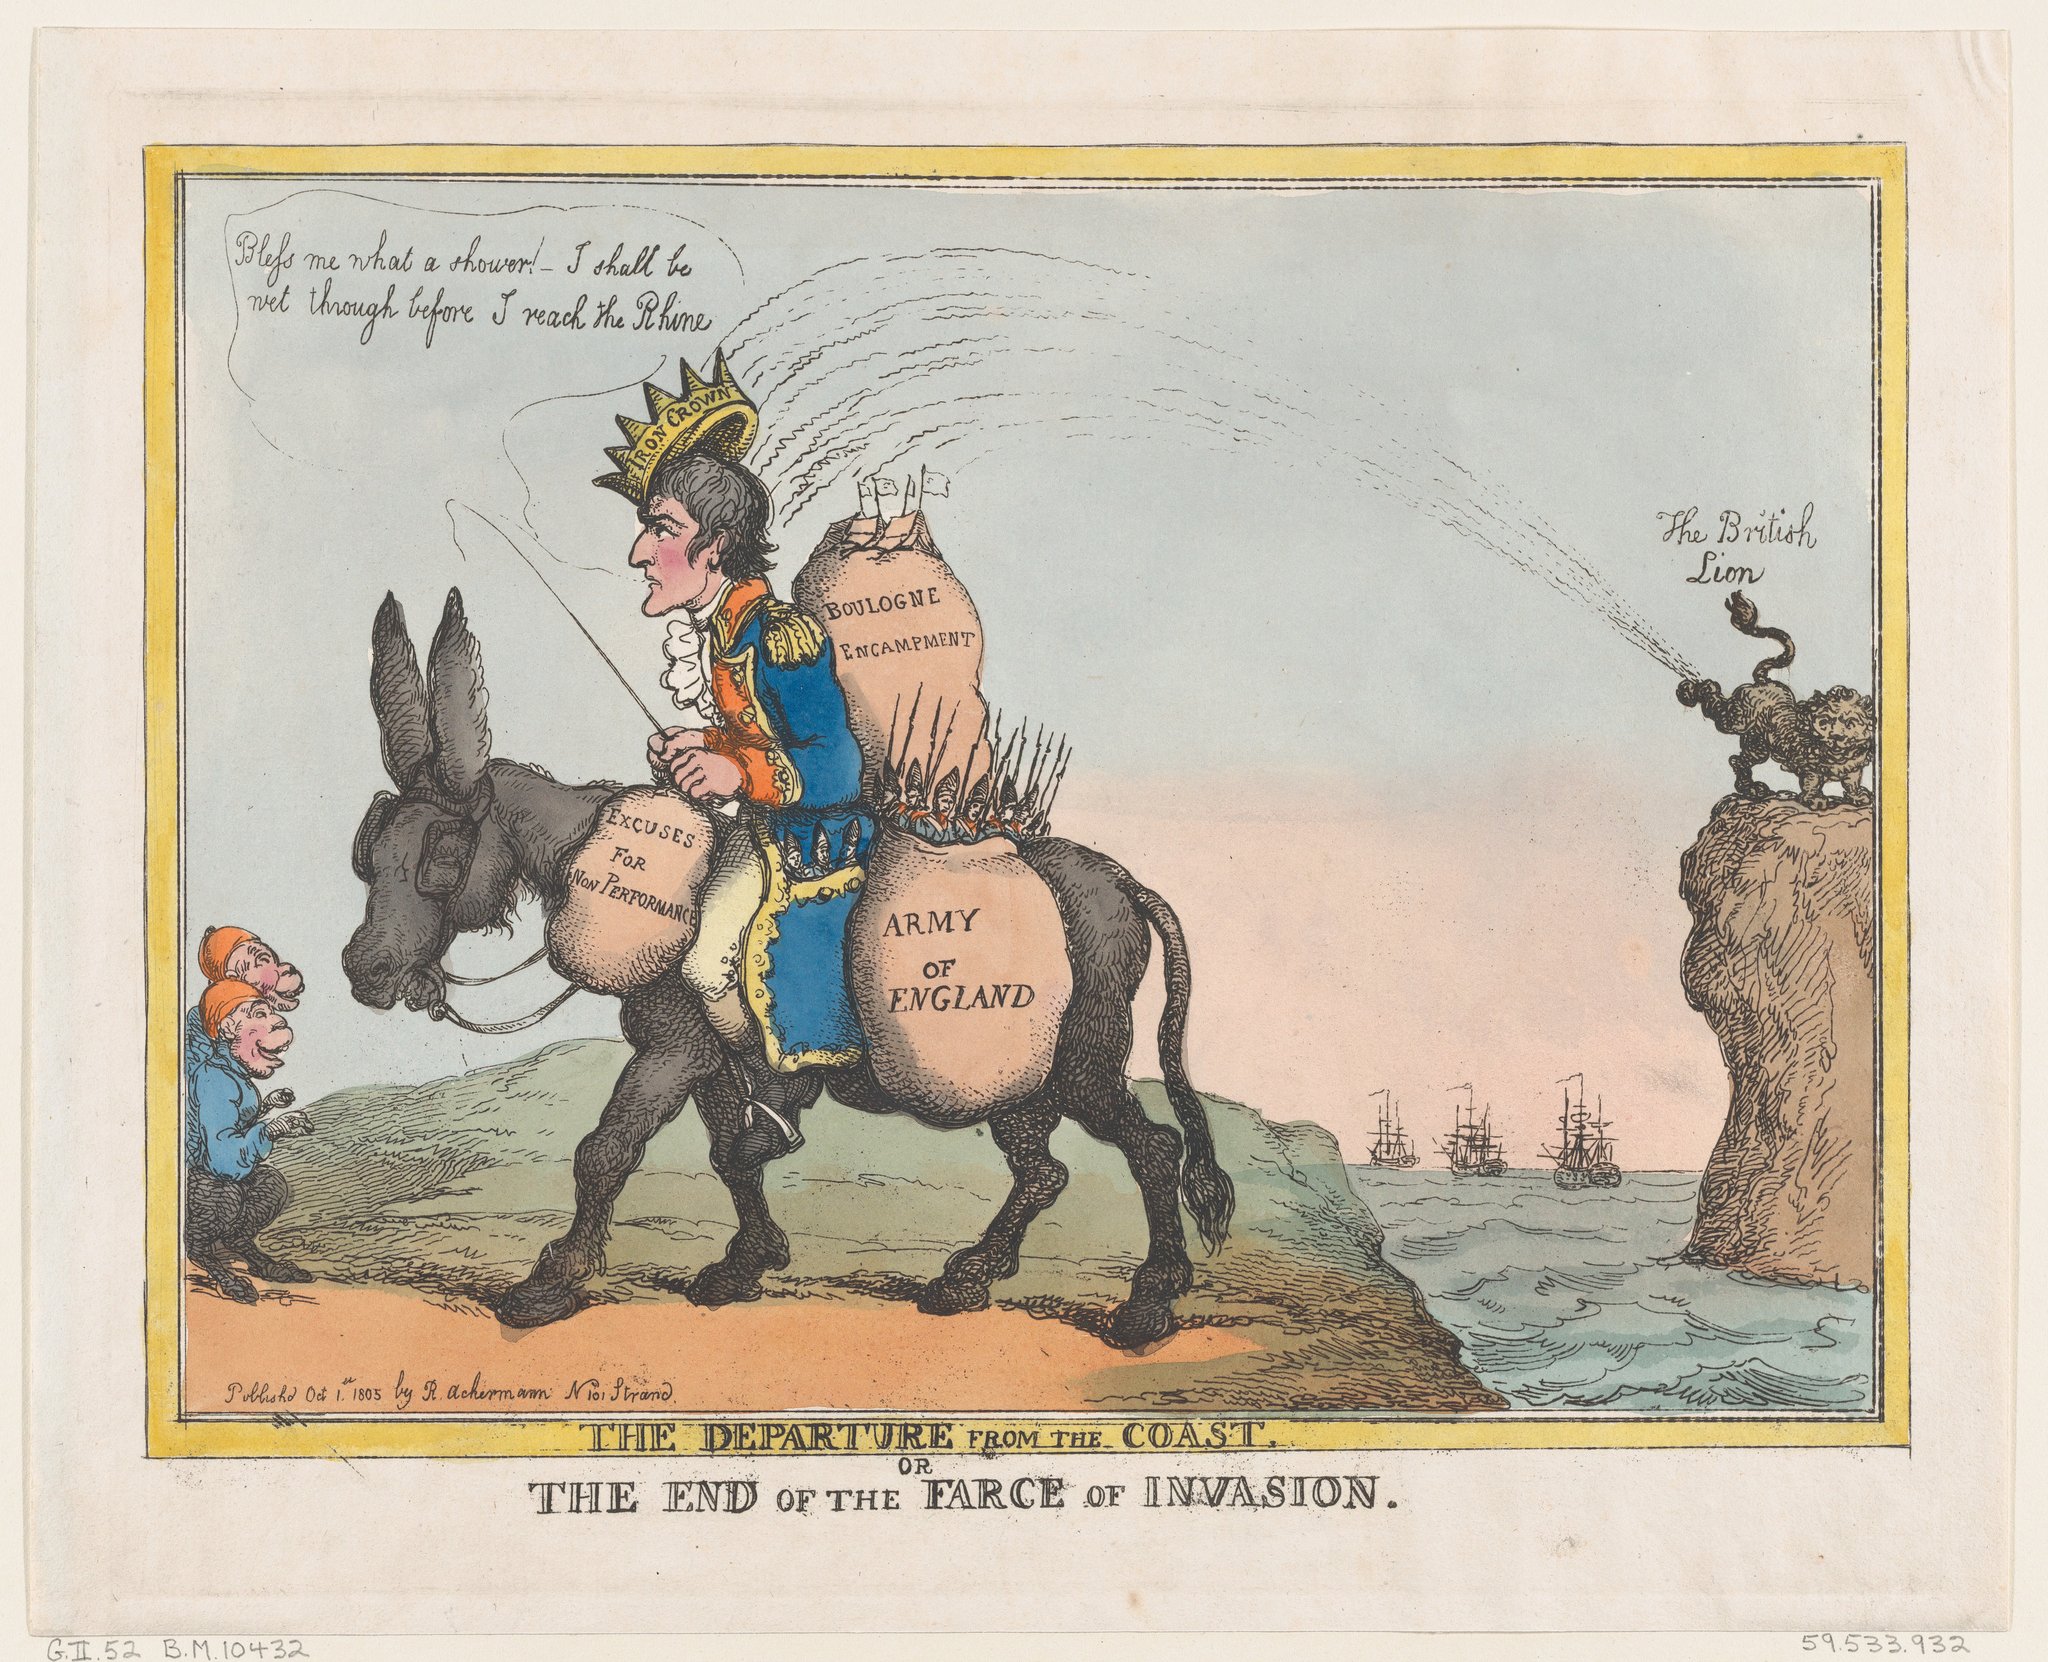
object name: print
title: The Departure from the Coast, or the End of the Farce of Invasion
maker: thomas rowlandson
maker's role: artist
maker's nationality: british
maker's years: 1757-1827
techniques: etching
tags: satire,napoleon i,donkeys,politics